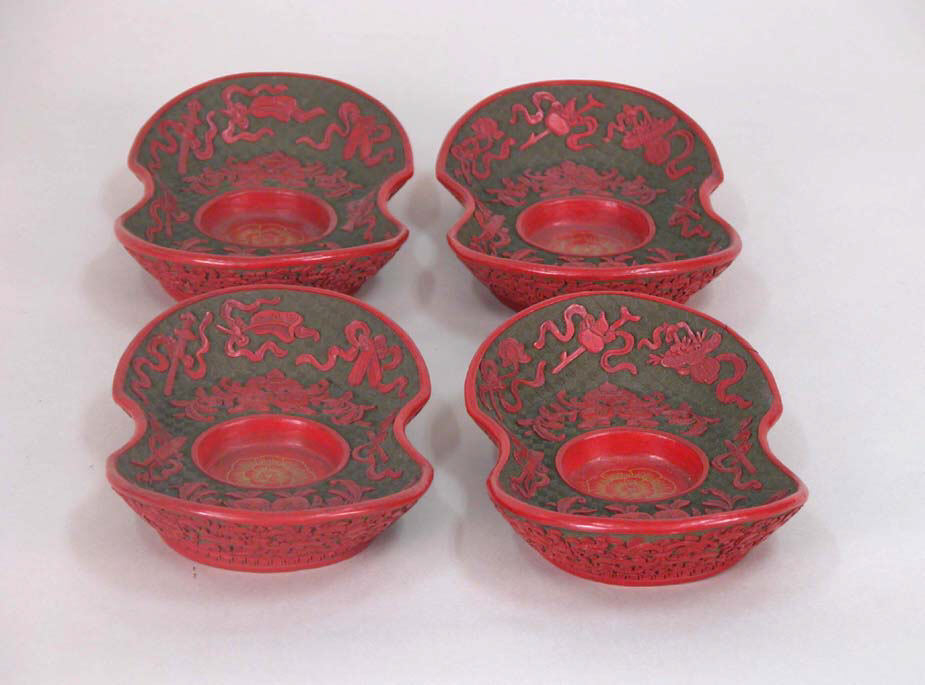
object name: saucer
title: Set of Four Saucers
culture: chinese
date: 1736-1795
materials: lacquer